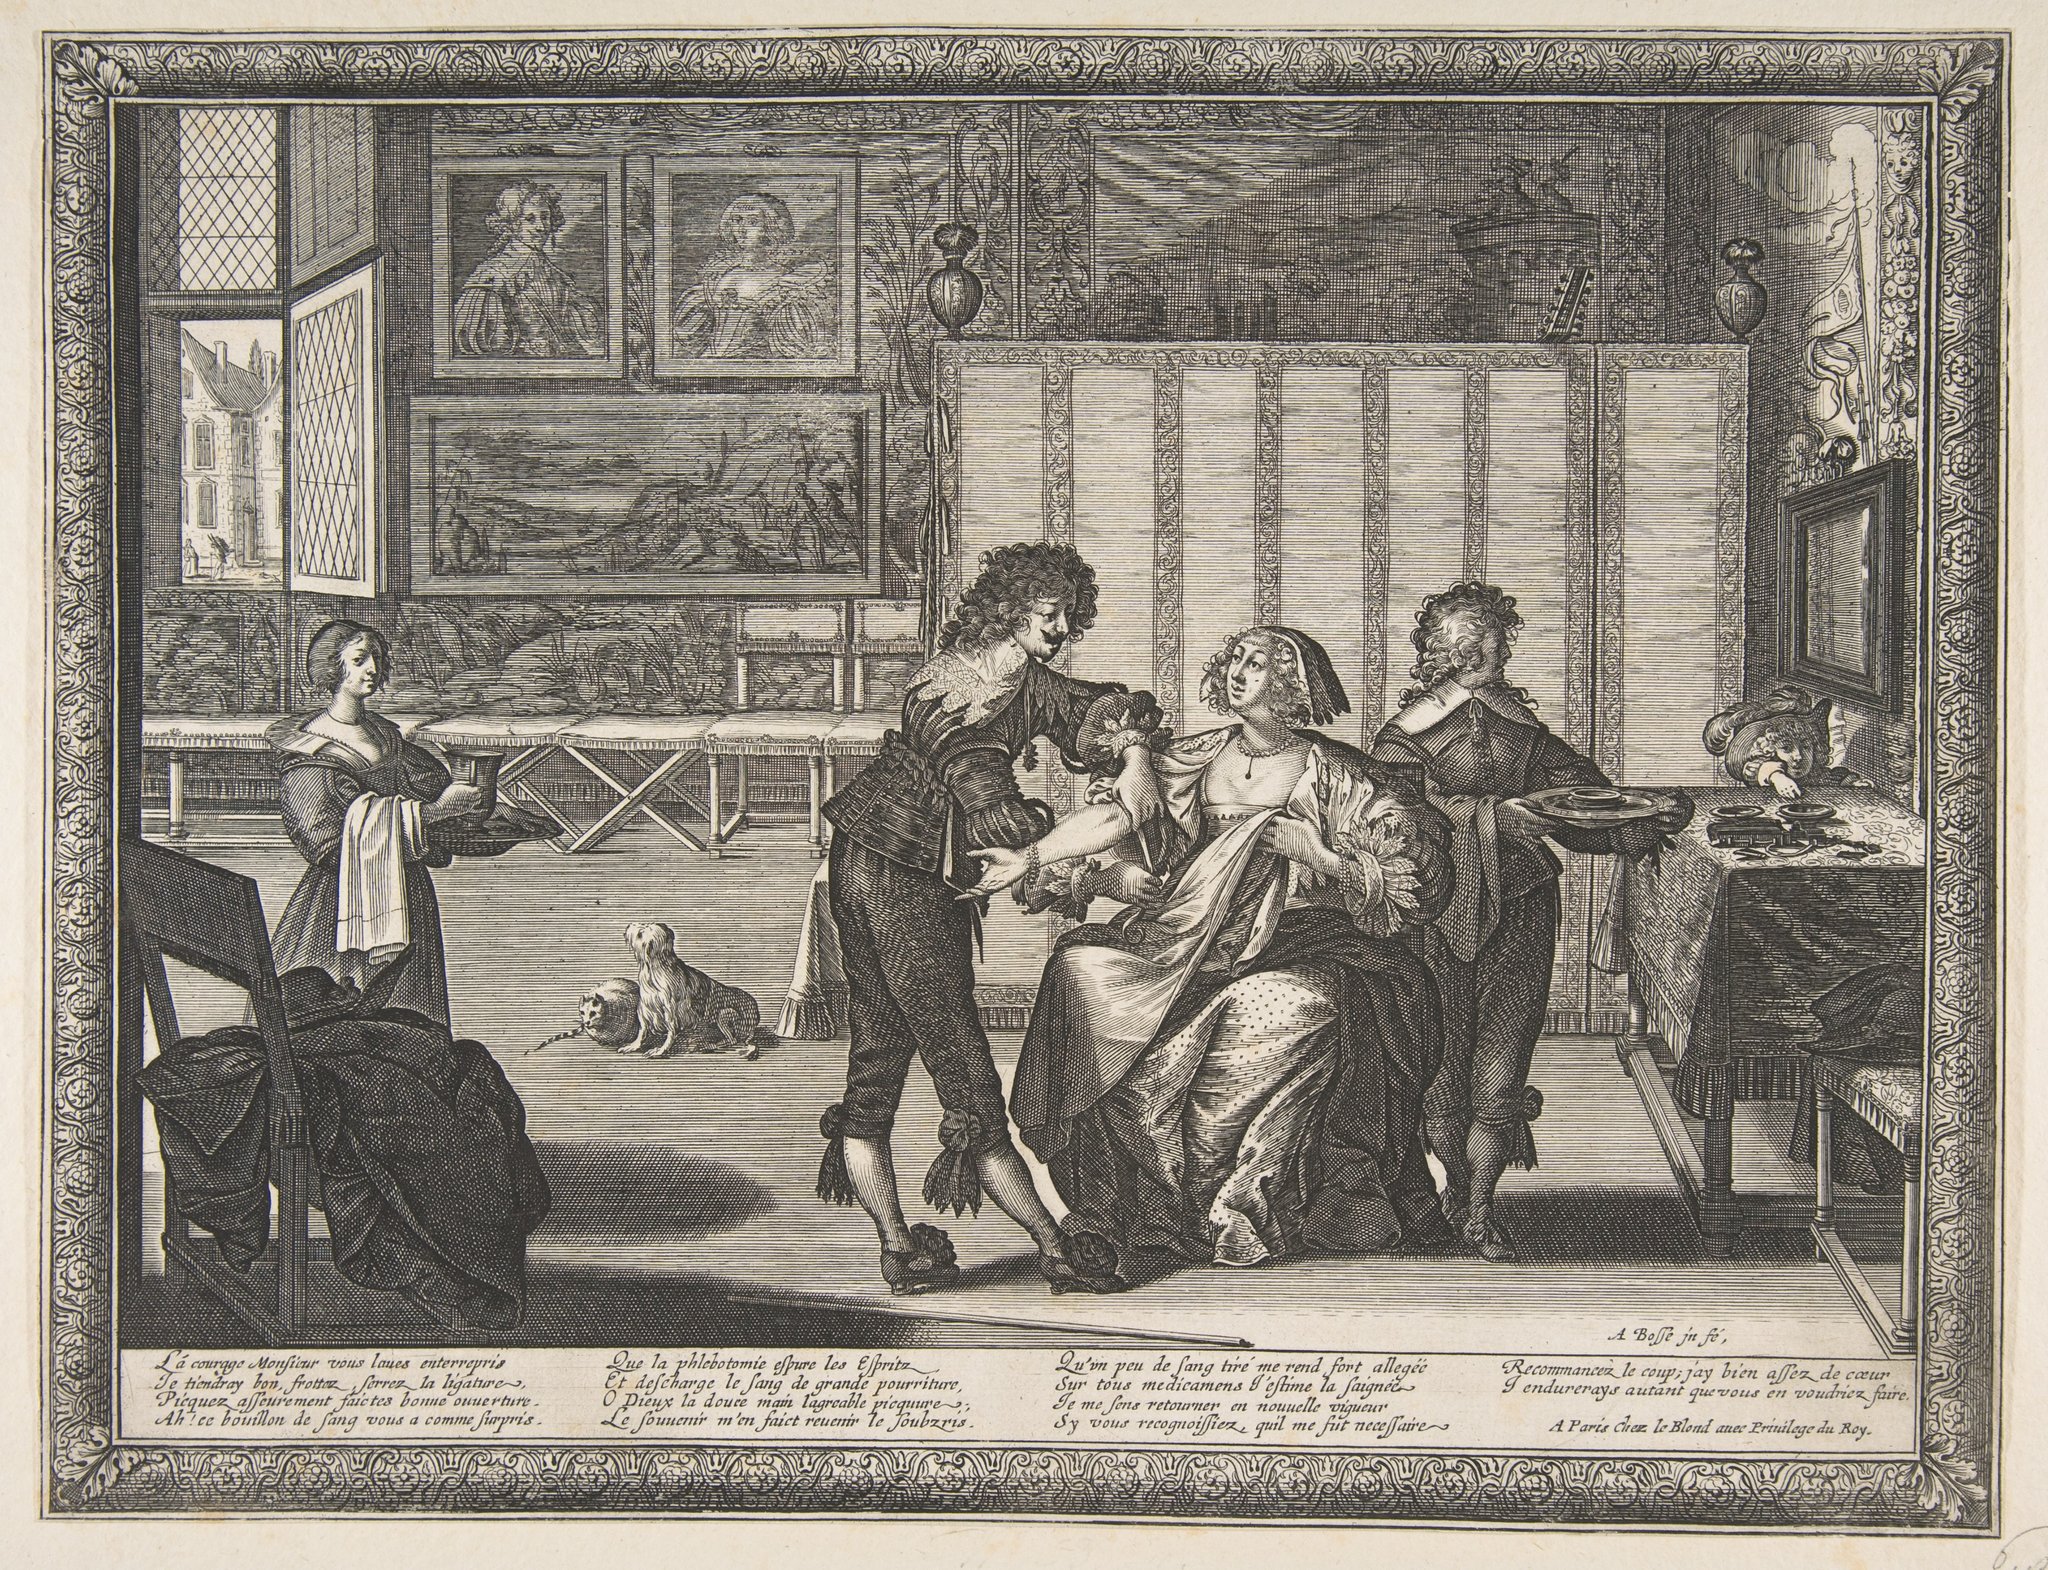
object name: print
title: The Surgeon (La Saignée)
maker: abraham bosse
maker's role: artist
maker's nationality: french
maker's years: 1602-1676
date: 1632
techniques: engraving, etching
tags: men,women,cats,dogs,doctors